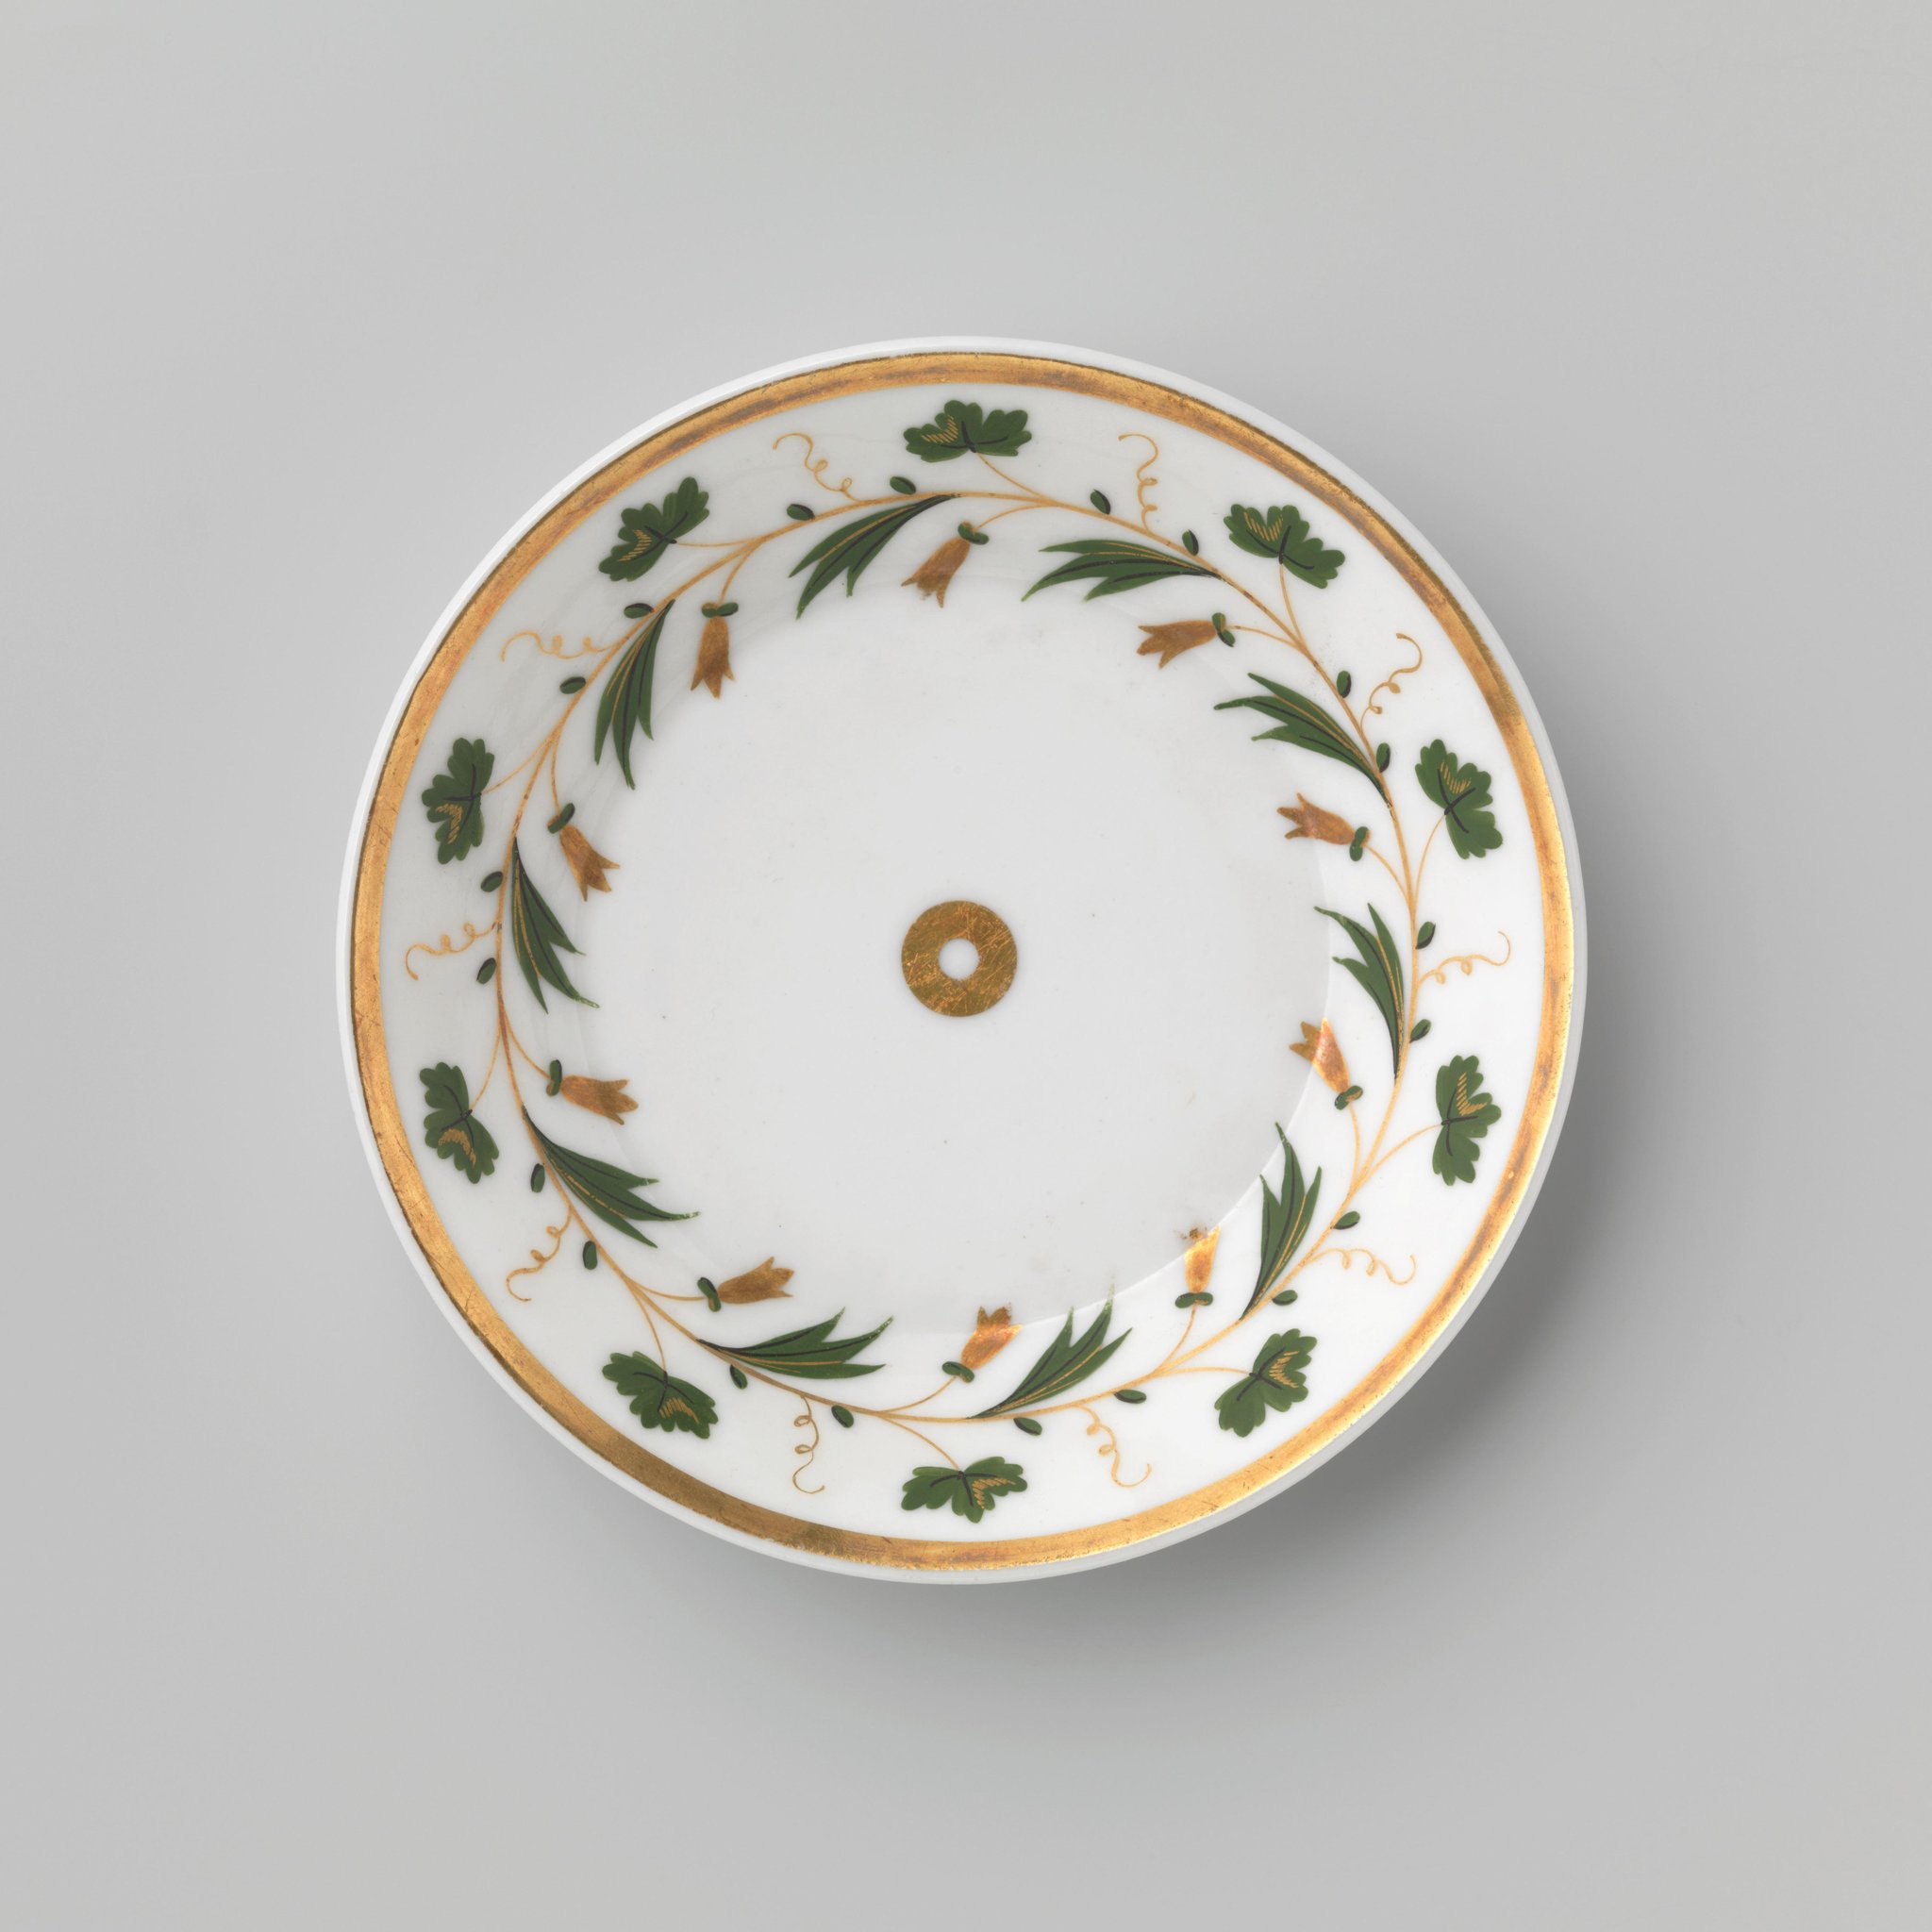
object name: platter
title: Saucer with a border of grapevines and flowers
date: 1800-1824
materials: glaze, gold, paint, porcelain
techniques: firing, forming, gilding, turning, vitrification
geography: paris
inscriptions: mark: ‘gekruiste pijlen’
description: Schotel van porselein met een rechte wand, beschilderd op het glazuur in groen, zwart en goud. In het centrum een gouden cirkel. Op de wand een band met aan de ene zijde wijnranken en aan de andere zijde bloemen en bladeren. Gouden rand. Gemerkt op de onderzijde met de gekruiste pijlen.